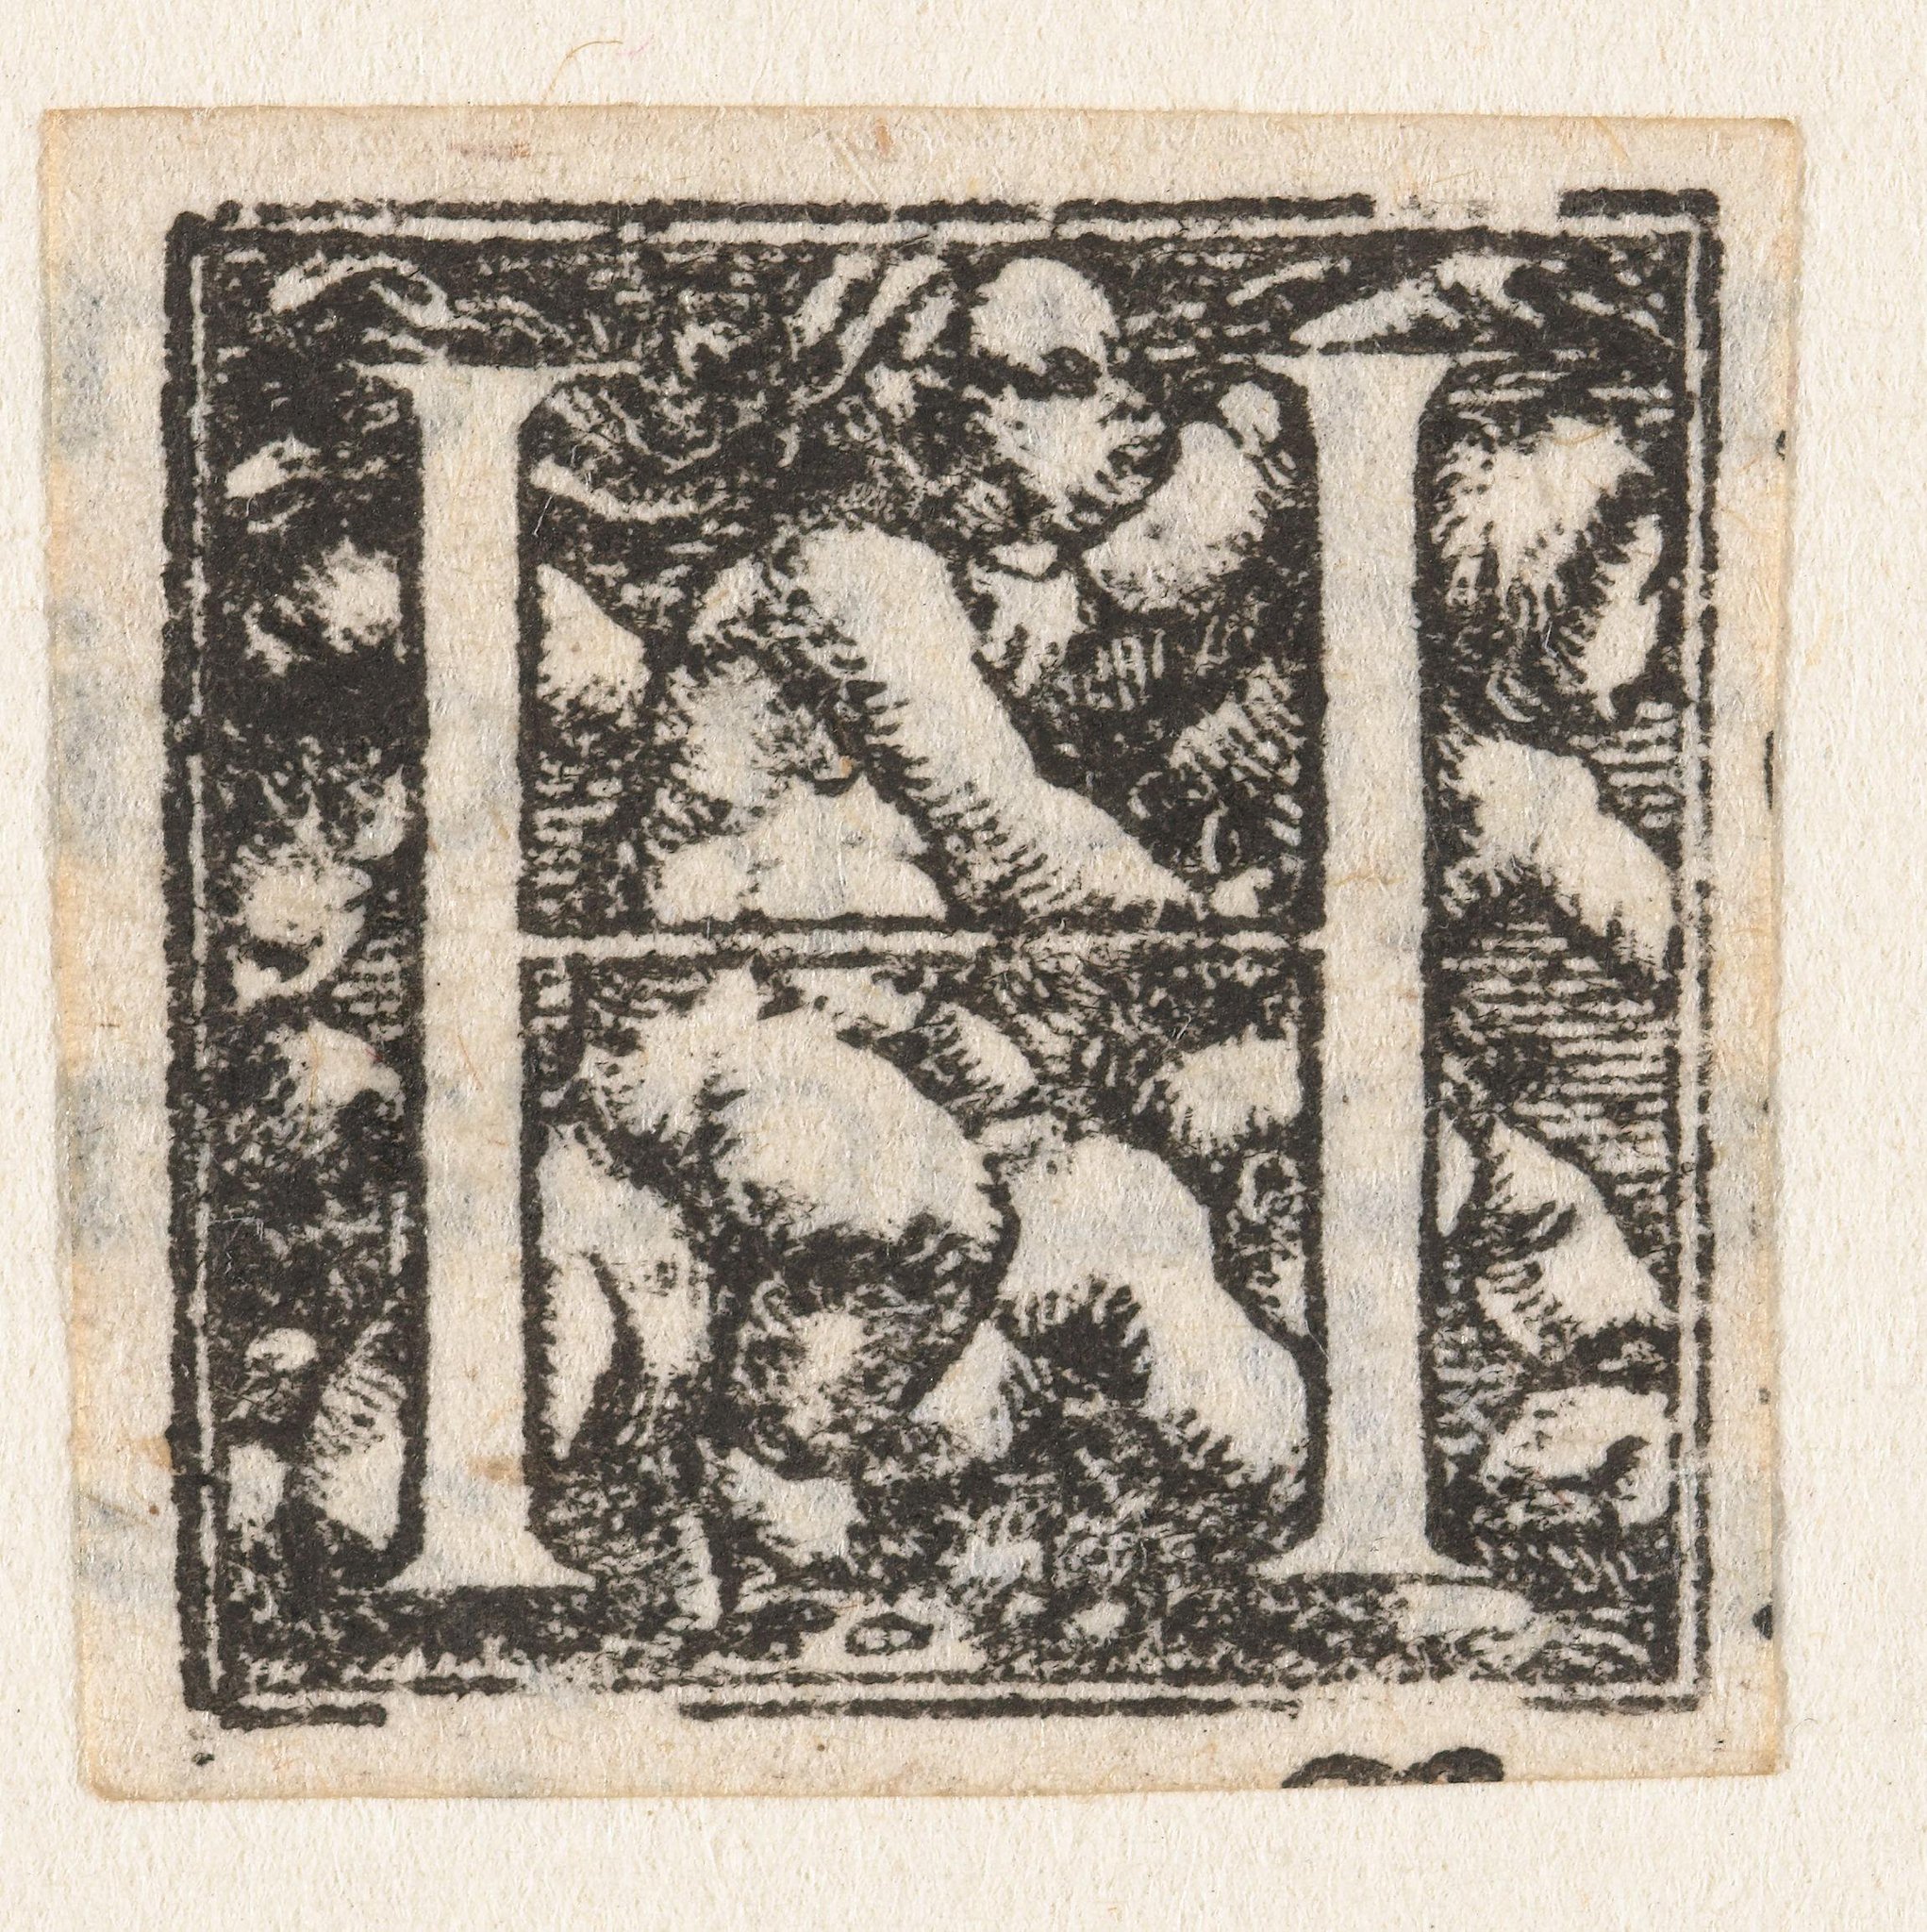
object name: print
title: Alfabet met kinderen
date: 1522-1526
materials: paper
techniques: woodcut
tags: letters, alphabet, script, child